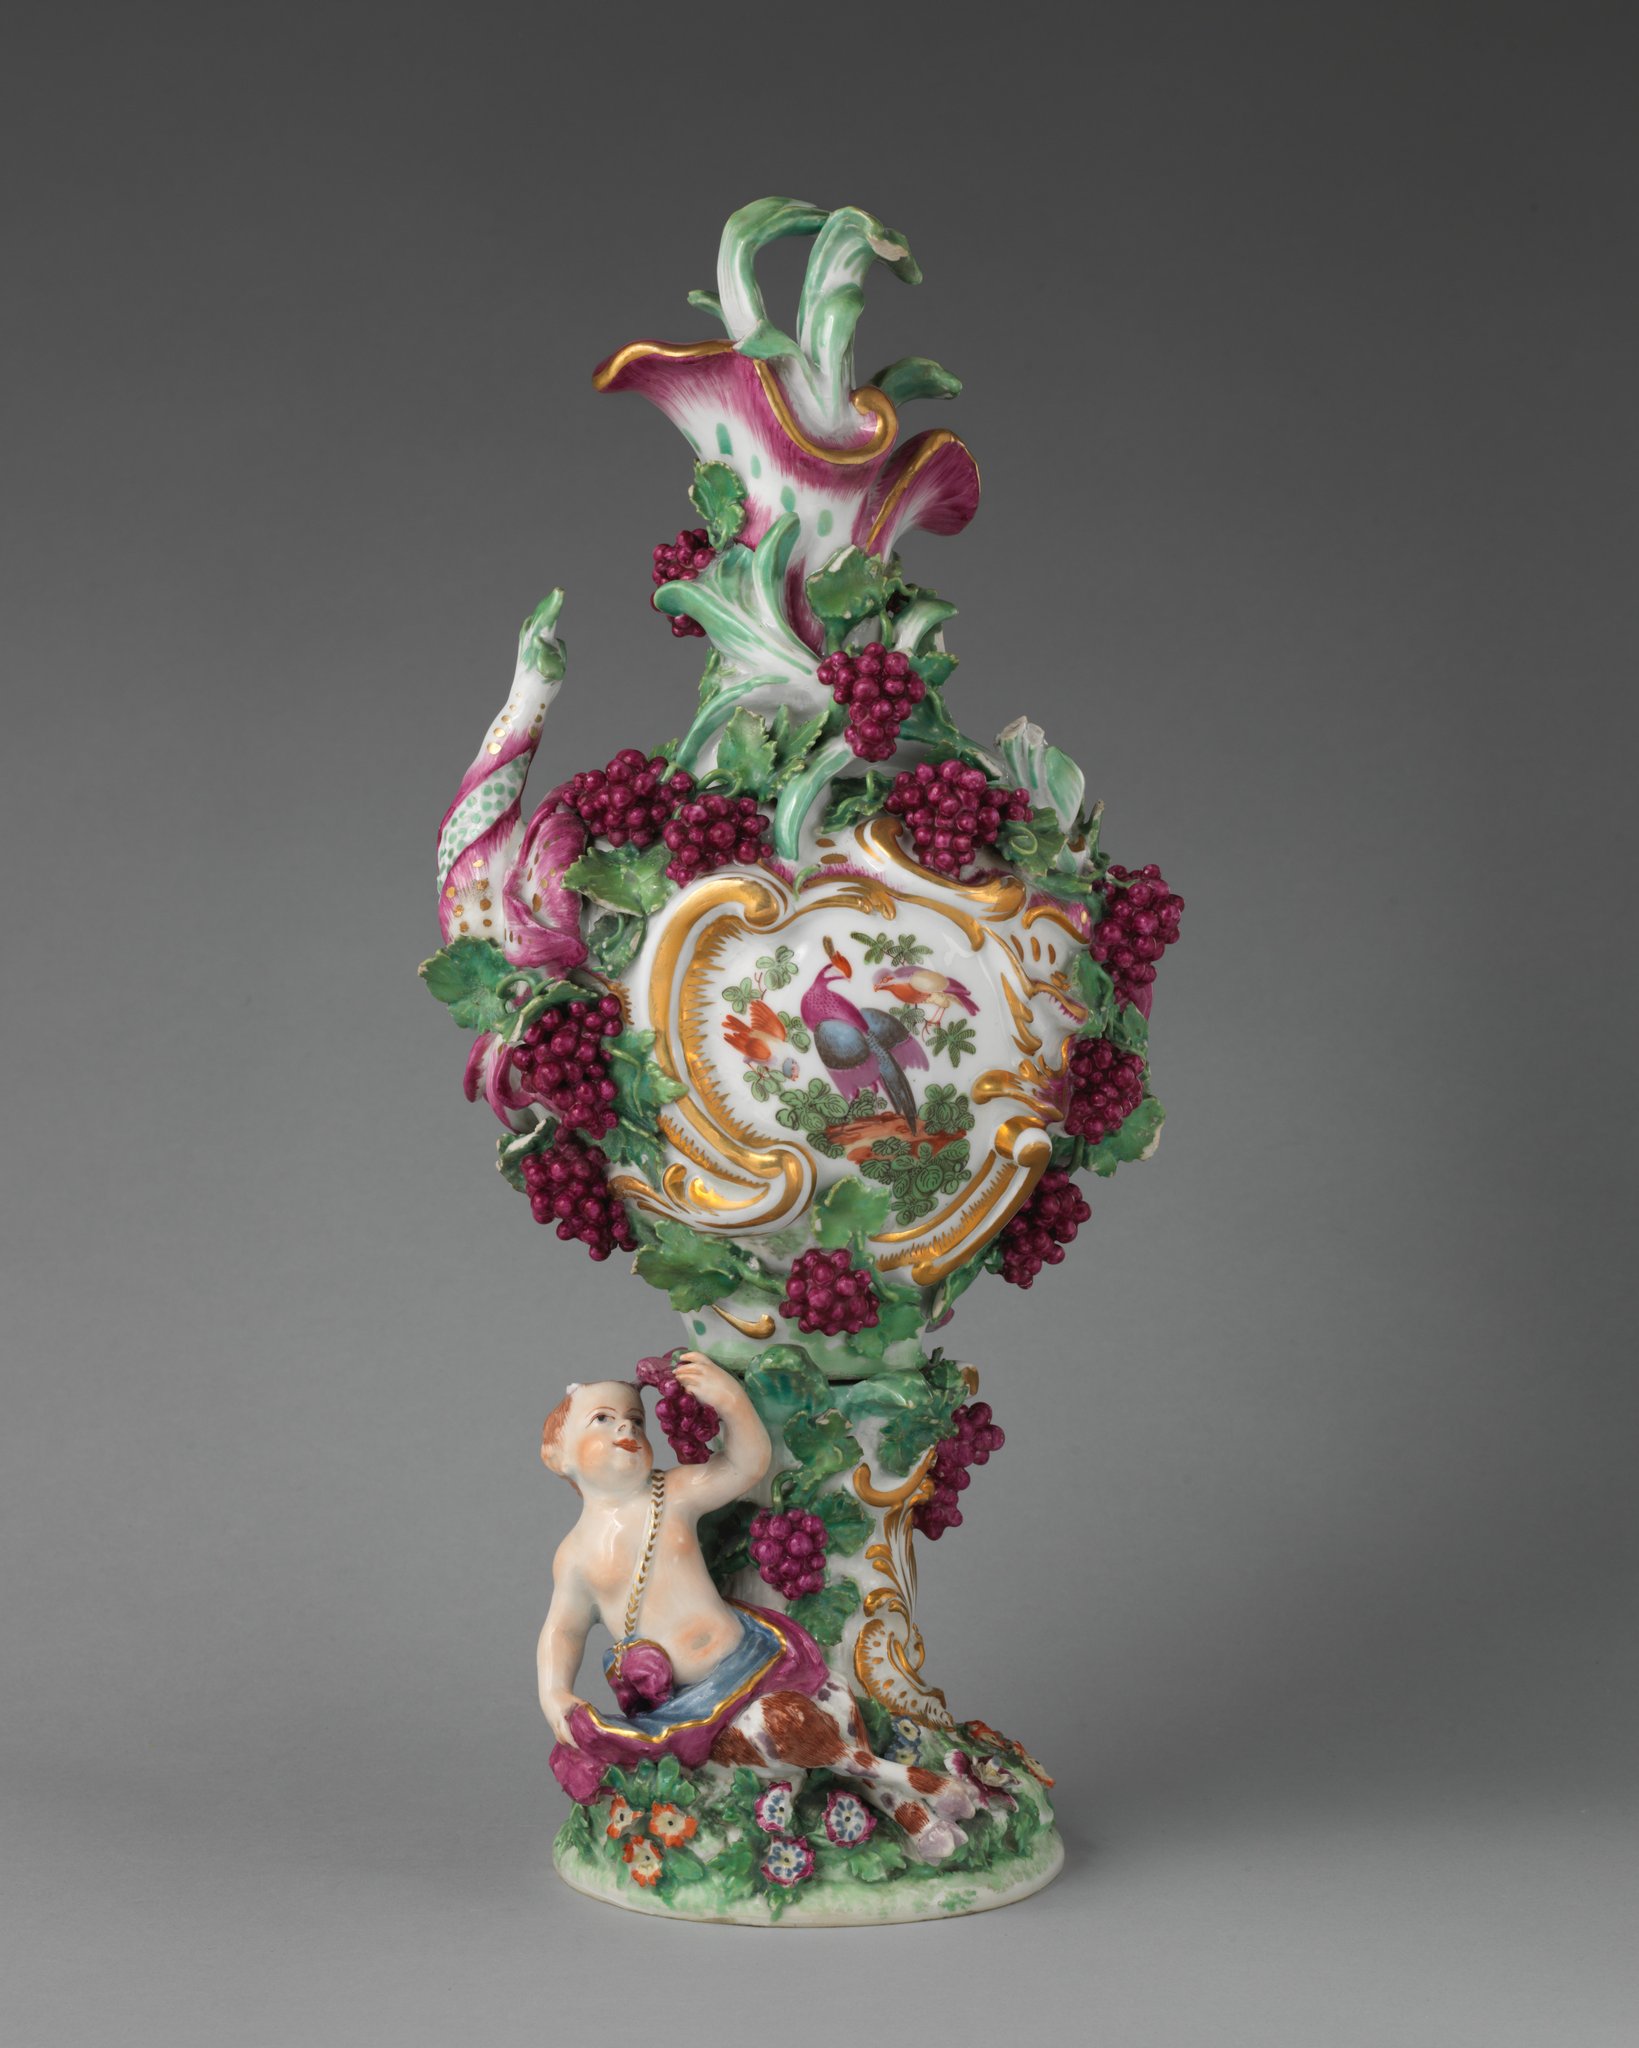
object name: vase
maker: chelsea porcelain manufactory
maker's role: factory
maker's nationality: british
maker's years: 1744-1784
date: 1760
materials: soft paste porcelain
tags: birds,grapes,children